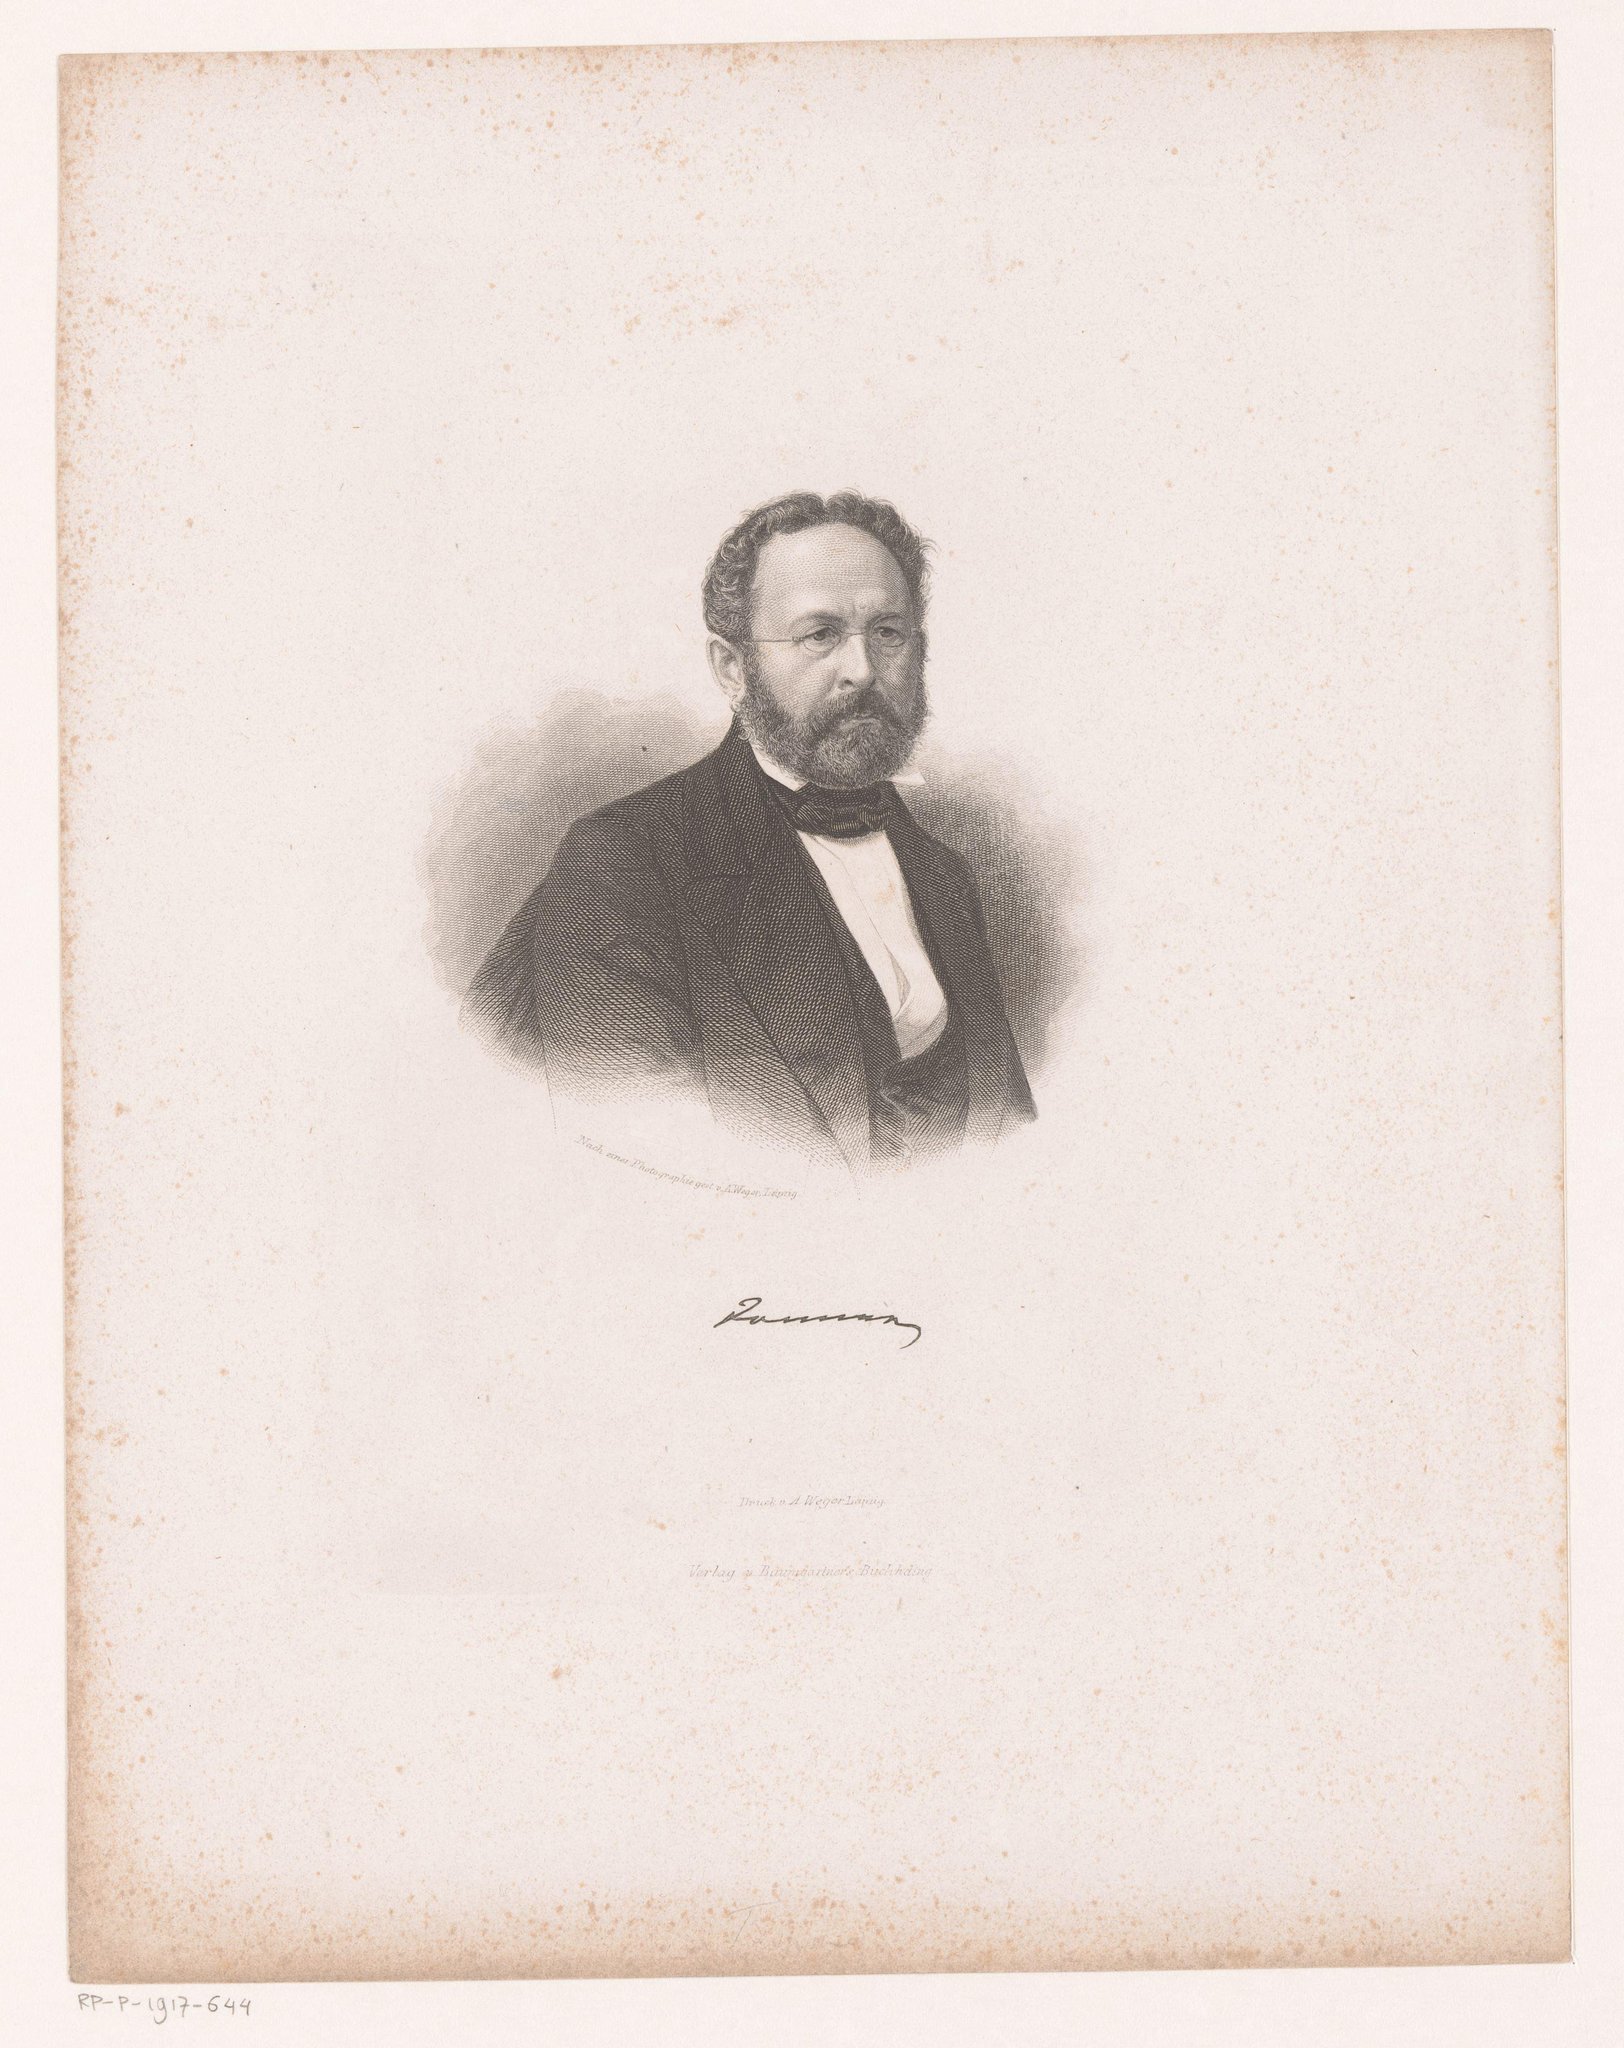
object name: print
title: Portret van Jodocus Temme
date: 1849-1892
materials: paper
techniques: engraving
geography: leipzig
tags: historical persons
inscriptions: collector's mark: Lugt 2228